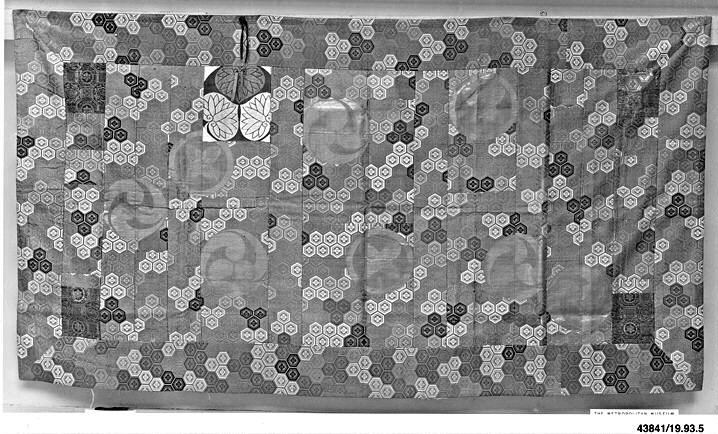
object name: robe, priest's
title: Priest's Robe (Shichijō)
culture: japanese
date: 1624-1644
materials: metal thread, silk